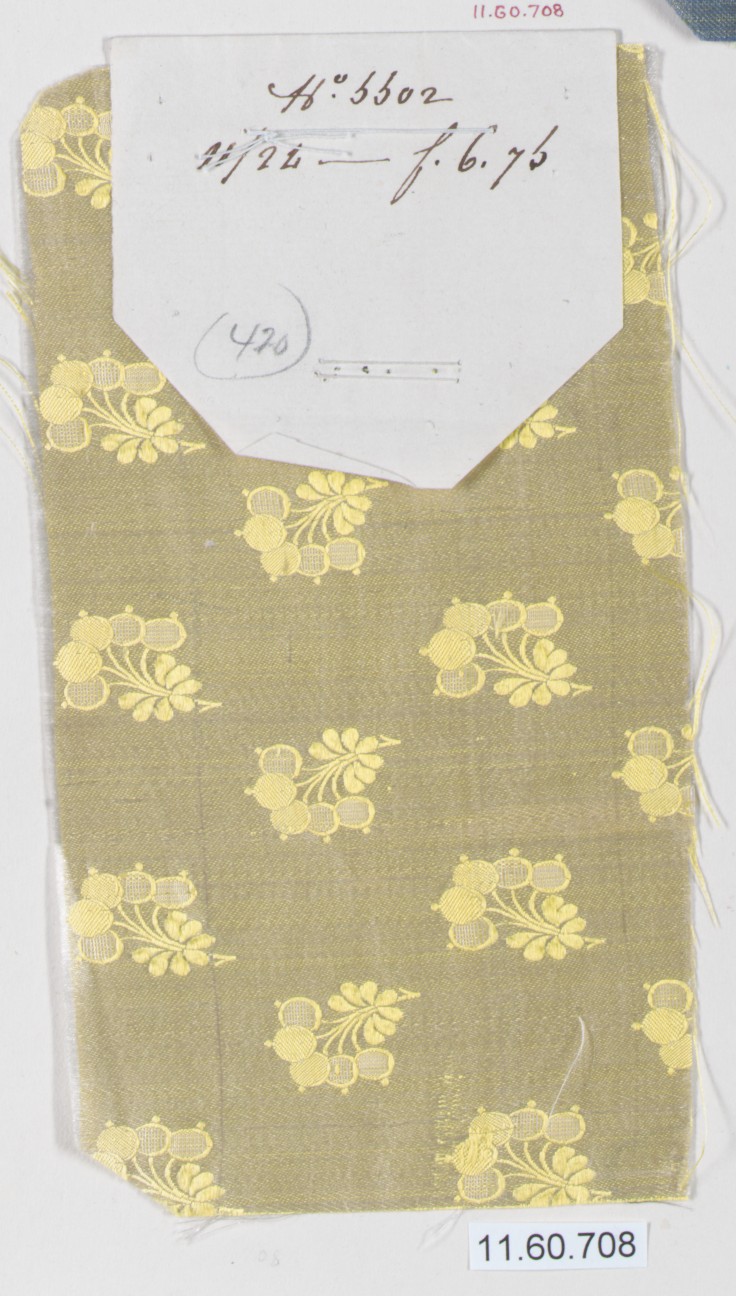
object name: sample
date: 1801-1850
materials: silk